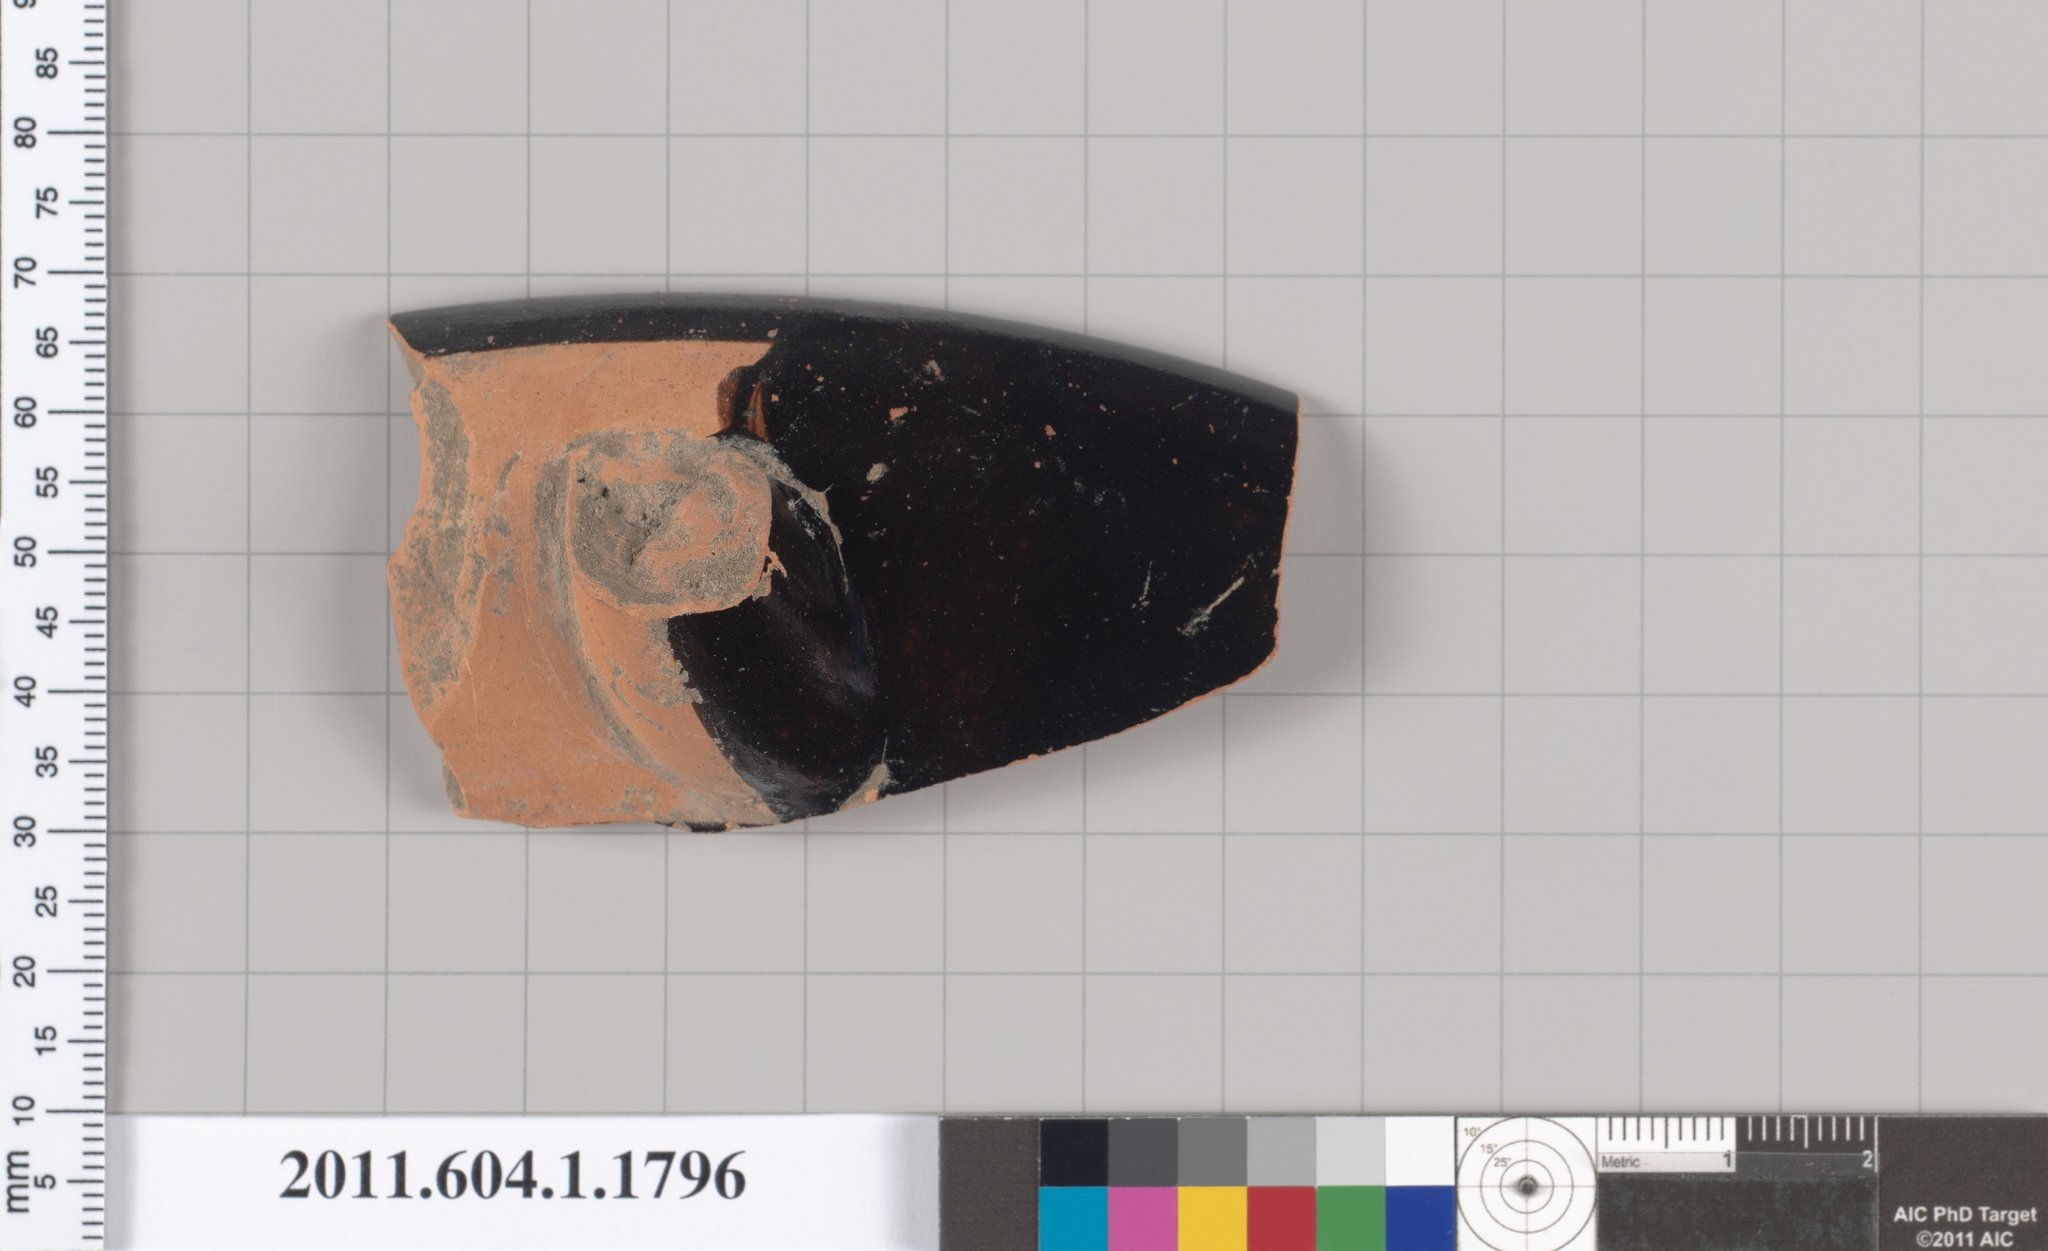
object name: kylix fragment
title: Terracotta rim fragment of a kylix (drinking cup)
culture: greek, attic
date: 500-401 BCE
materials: terracotta